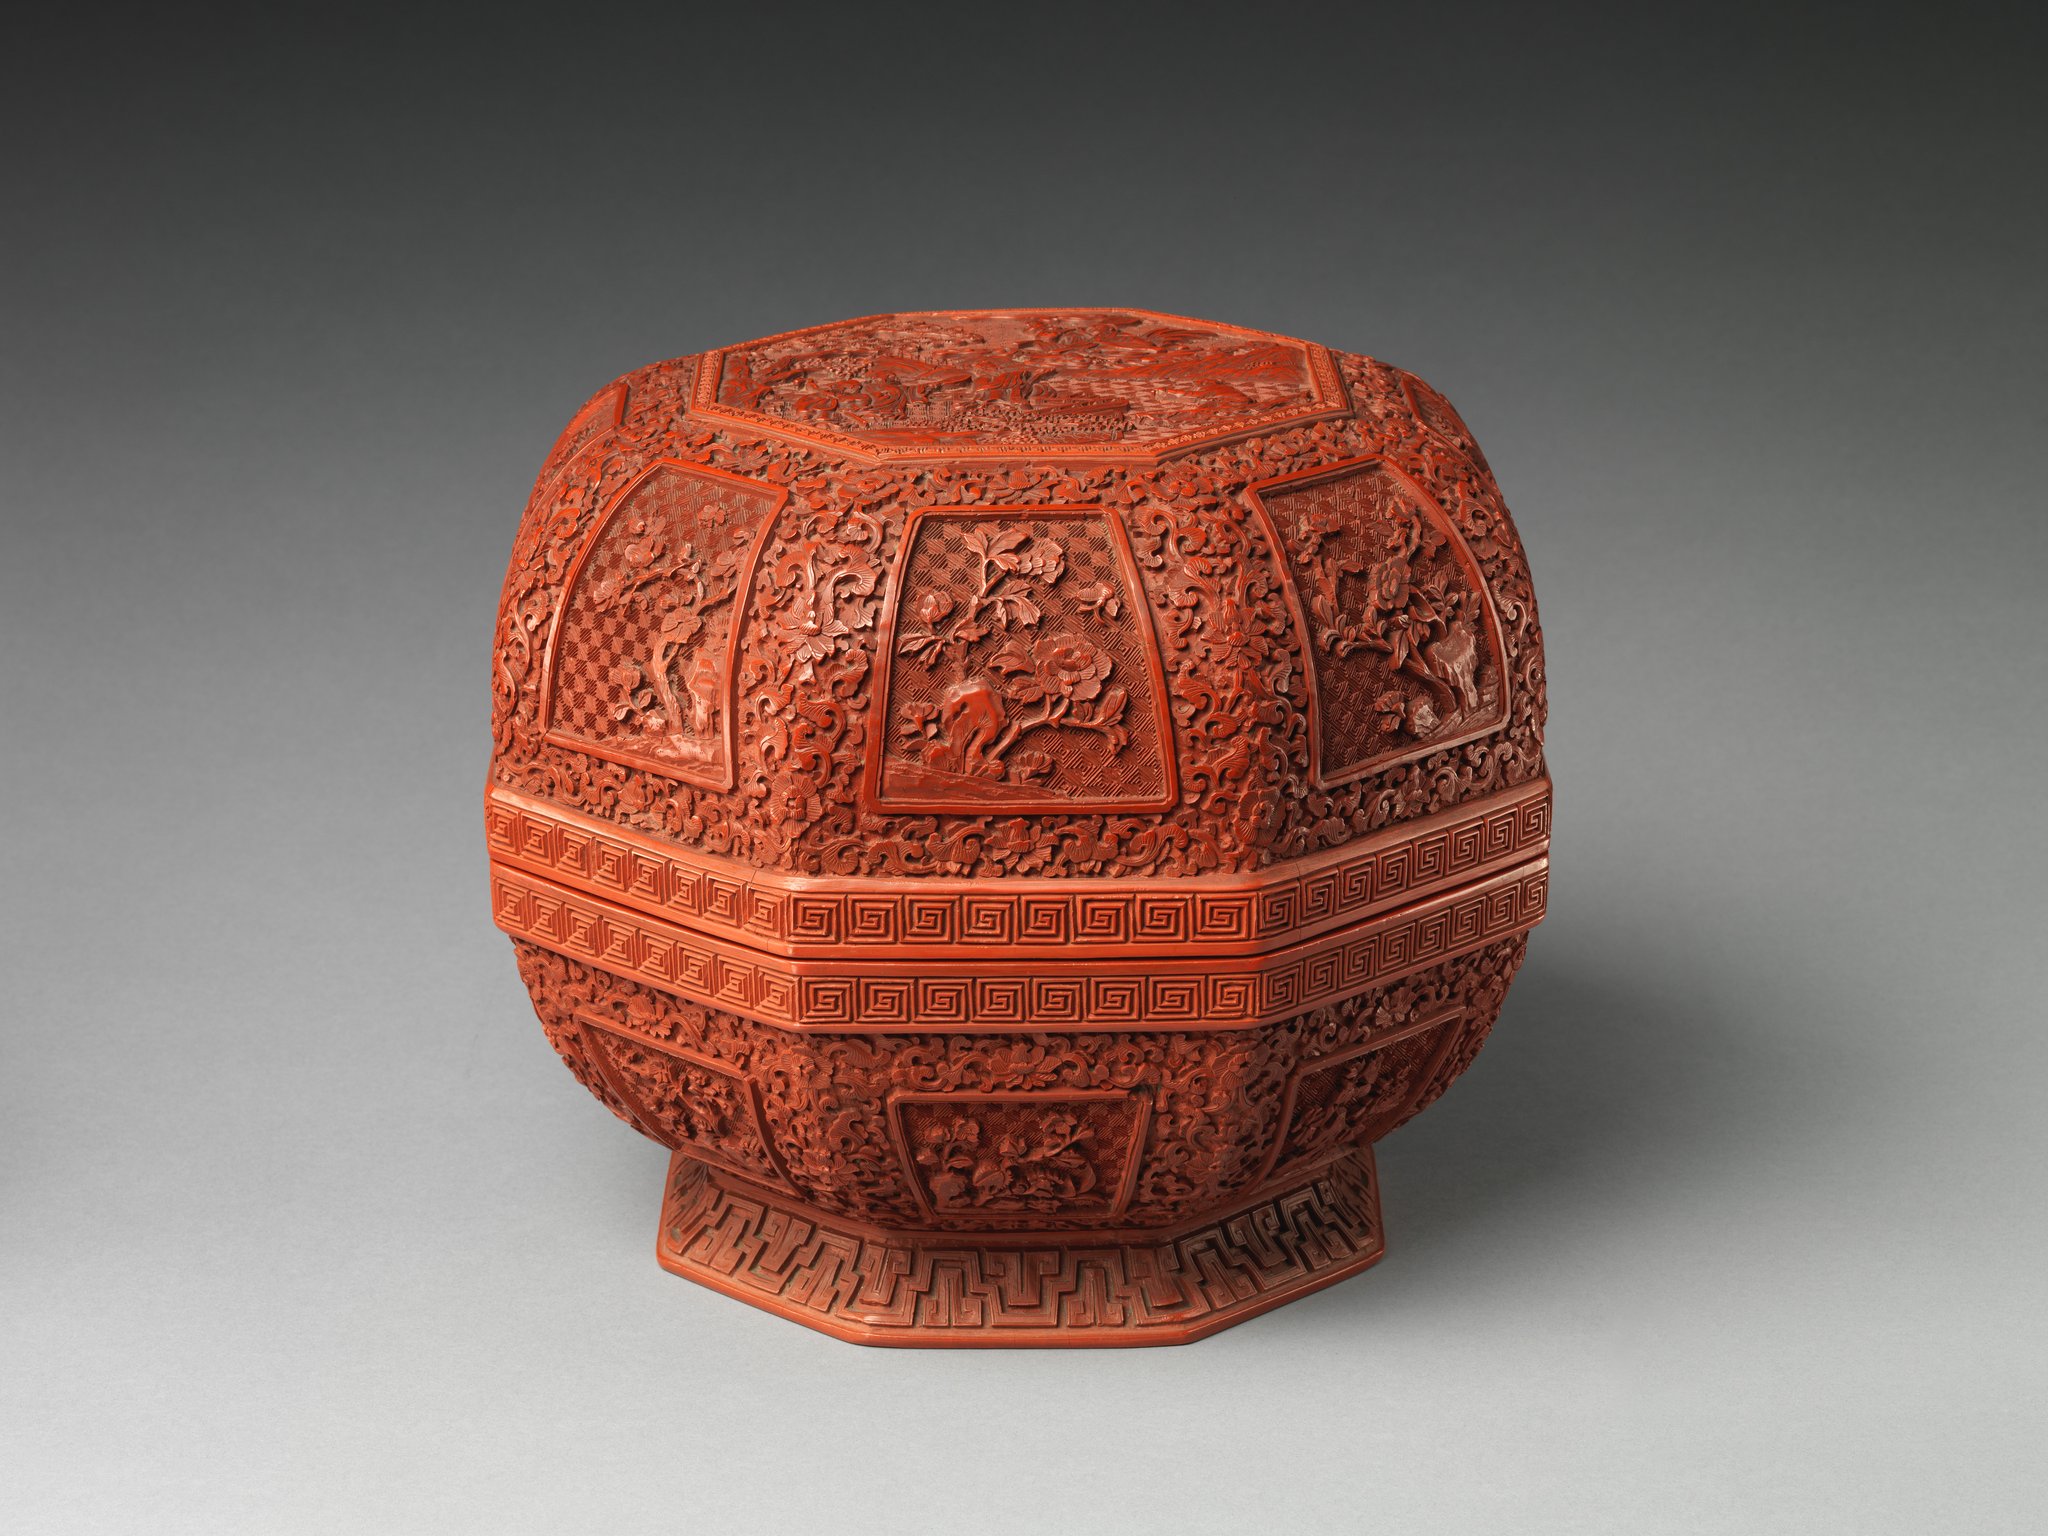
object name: octagonal box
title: Octagonal box with scene of immortals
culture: chinese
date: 1701-1800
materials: lacquer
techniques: carving